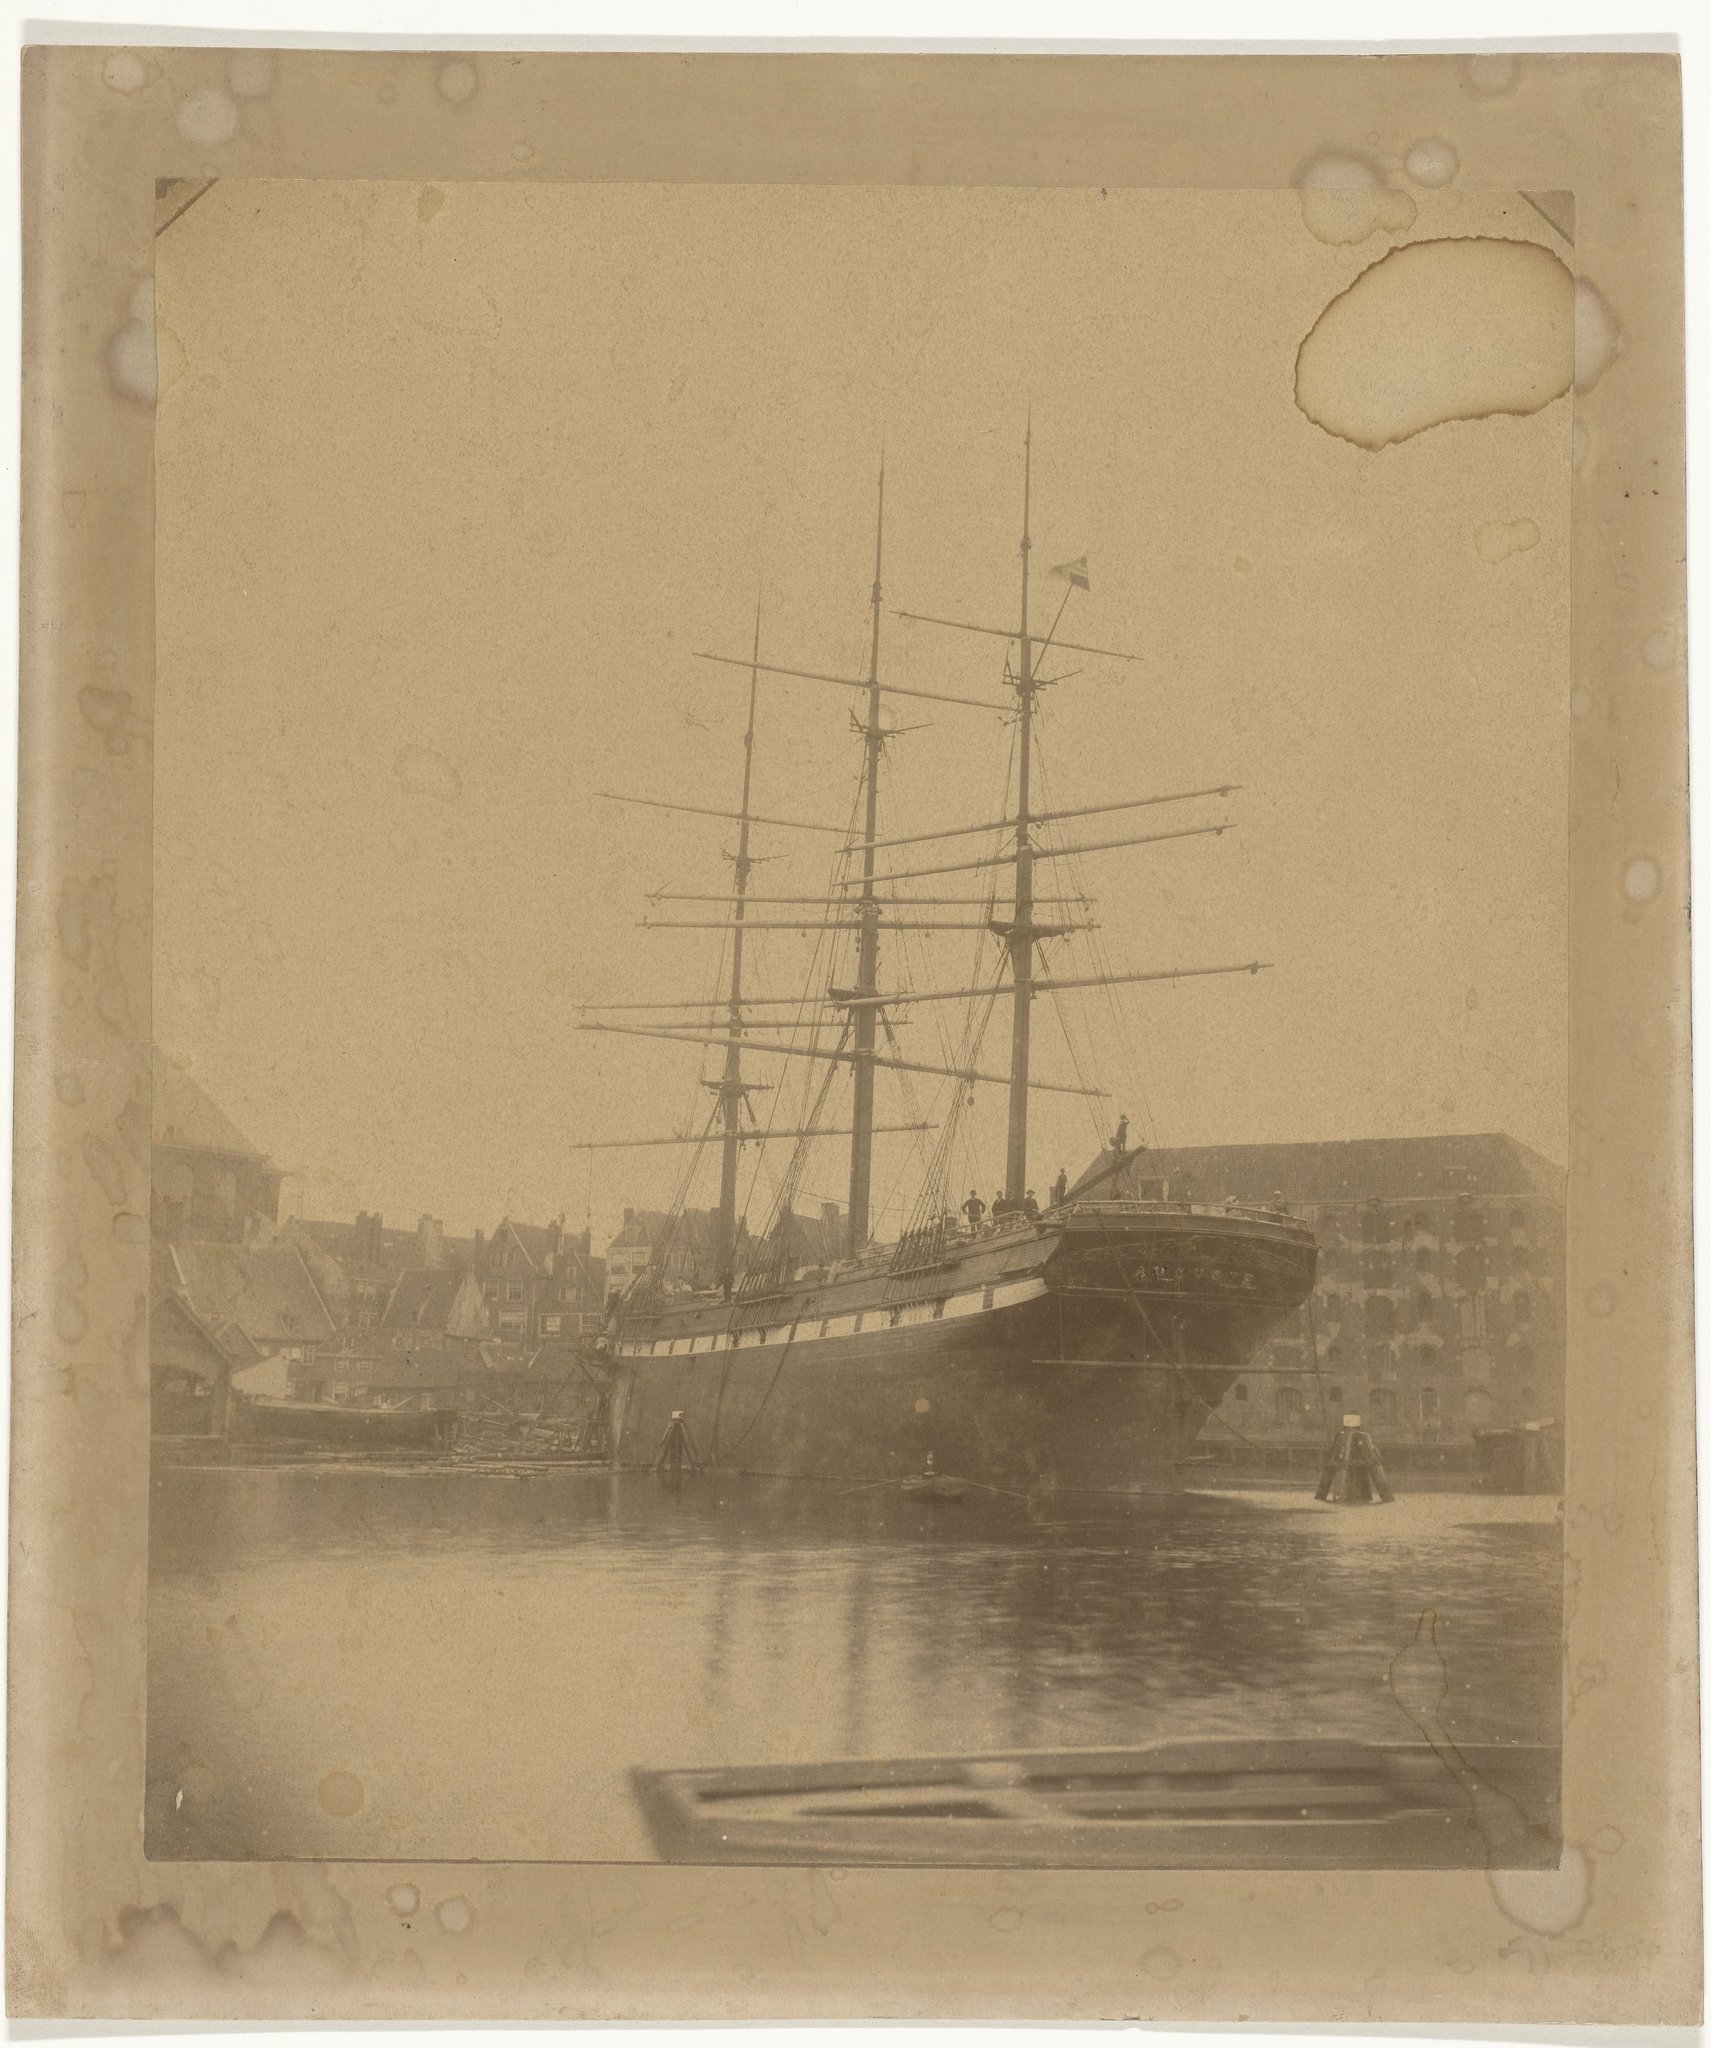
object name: photograph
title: Schip 'Auguste' aan werf in Amsterdam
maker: Anonymous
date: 1885-1900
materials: paper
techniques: albumen print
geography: amsterdam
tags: ships (in general)